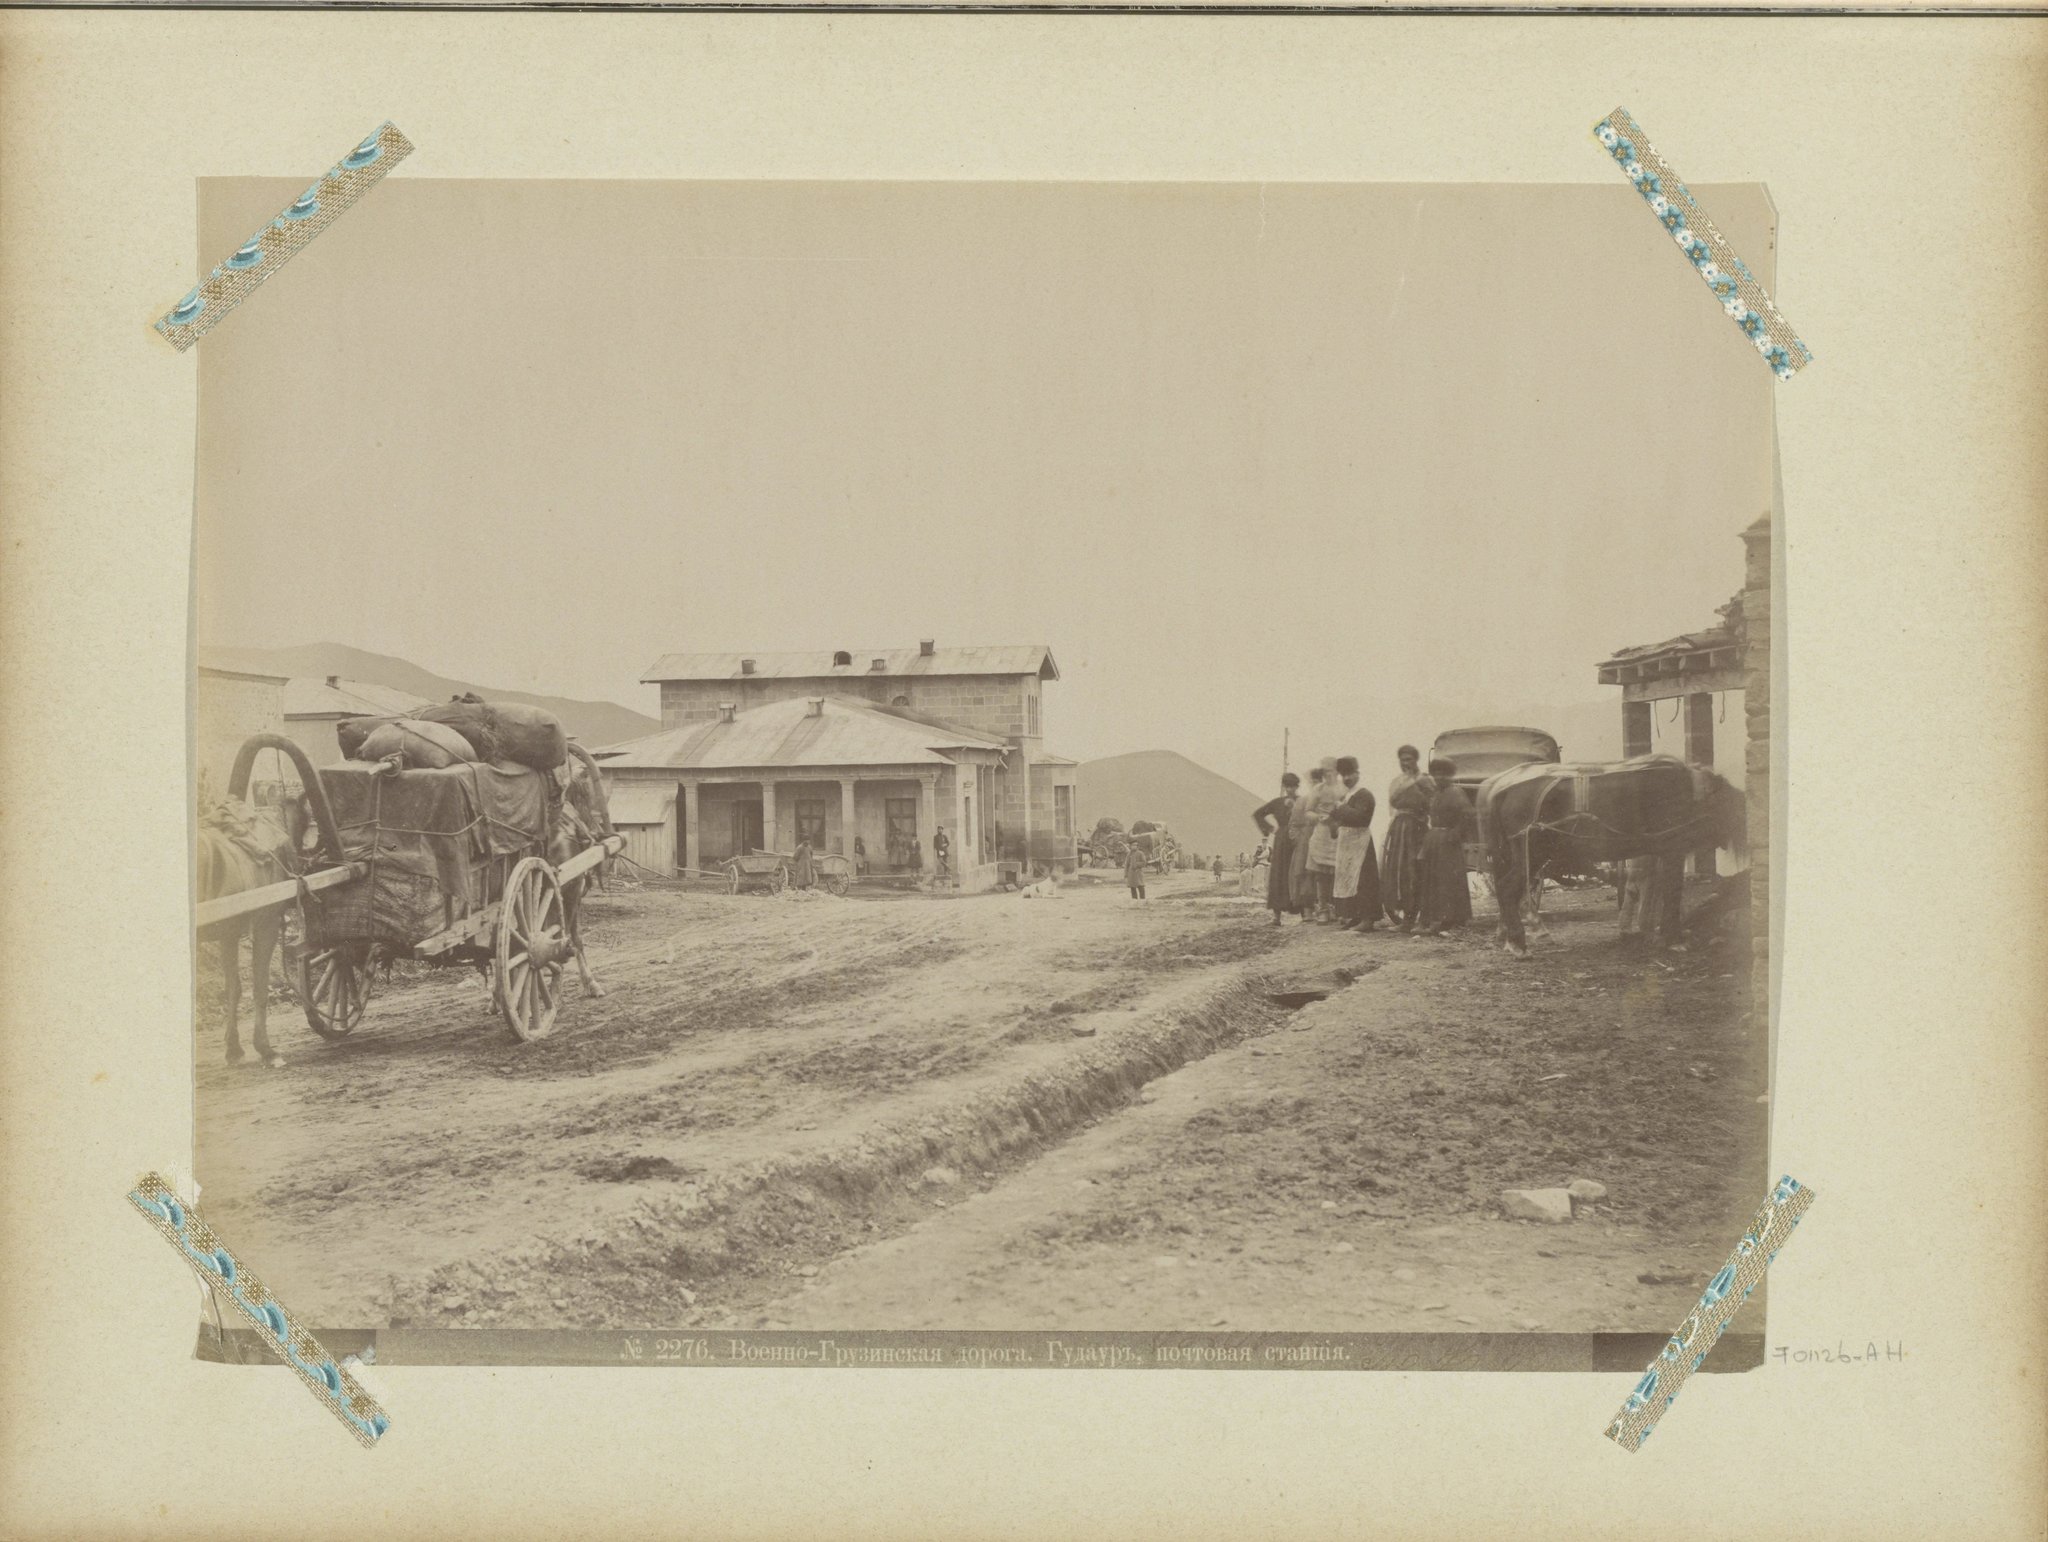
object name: photograph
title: Woenno-Groezinskaja doroga. Goedayoer, postowaja stanstja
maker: dimitri ivanovitch ermakov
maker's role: fotograaf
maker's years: 1845-1916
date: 1890-1900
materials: photographic support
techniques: albumen print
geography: georgia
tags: road, path, exterior ~ representation of a building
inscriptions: number: ‘2276’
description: Onderdeel van Fotoalbum met opnames van bezienswaardigheden in Georgië, Sint-Petersburg en Moskou.